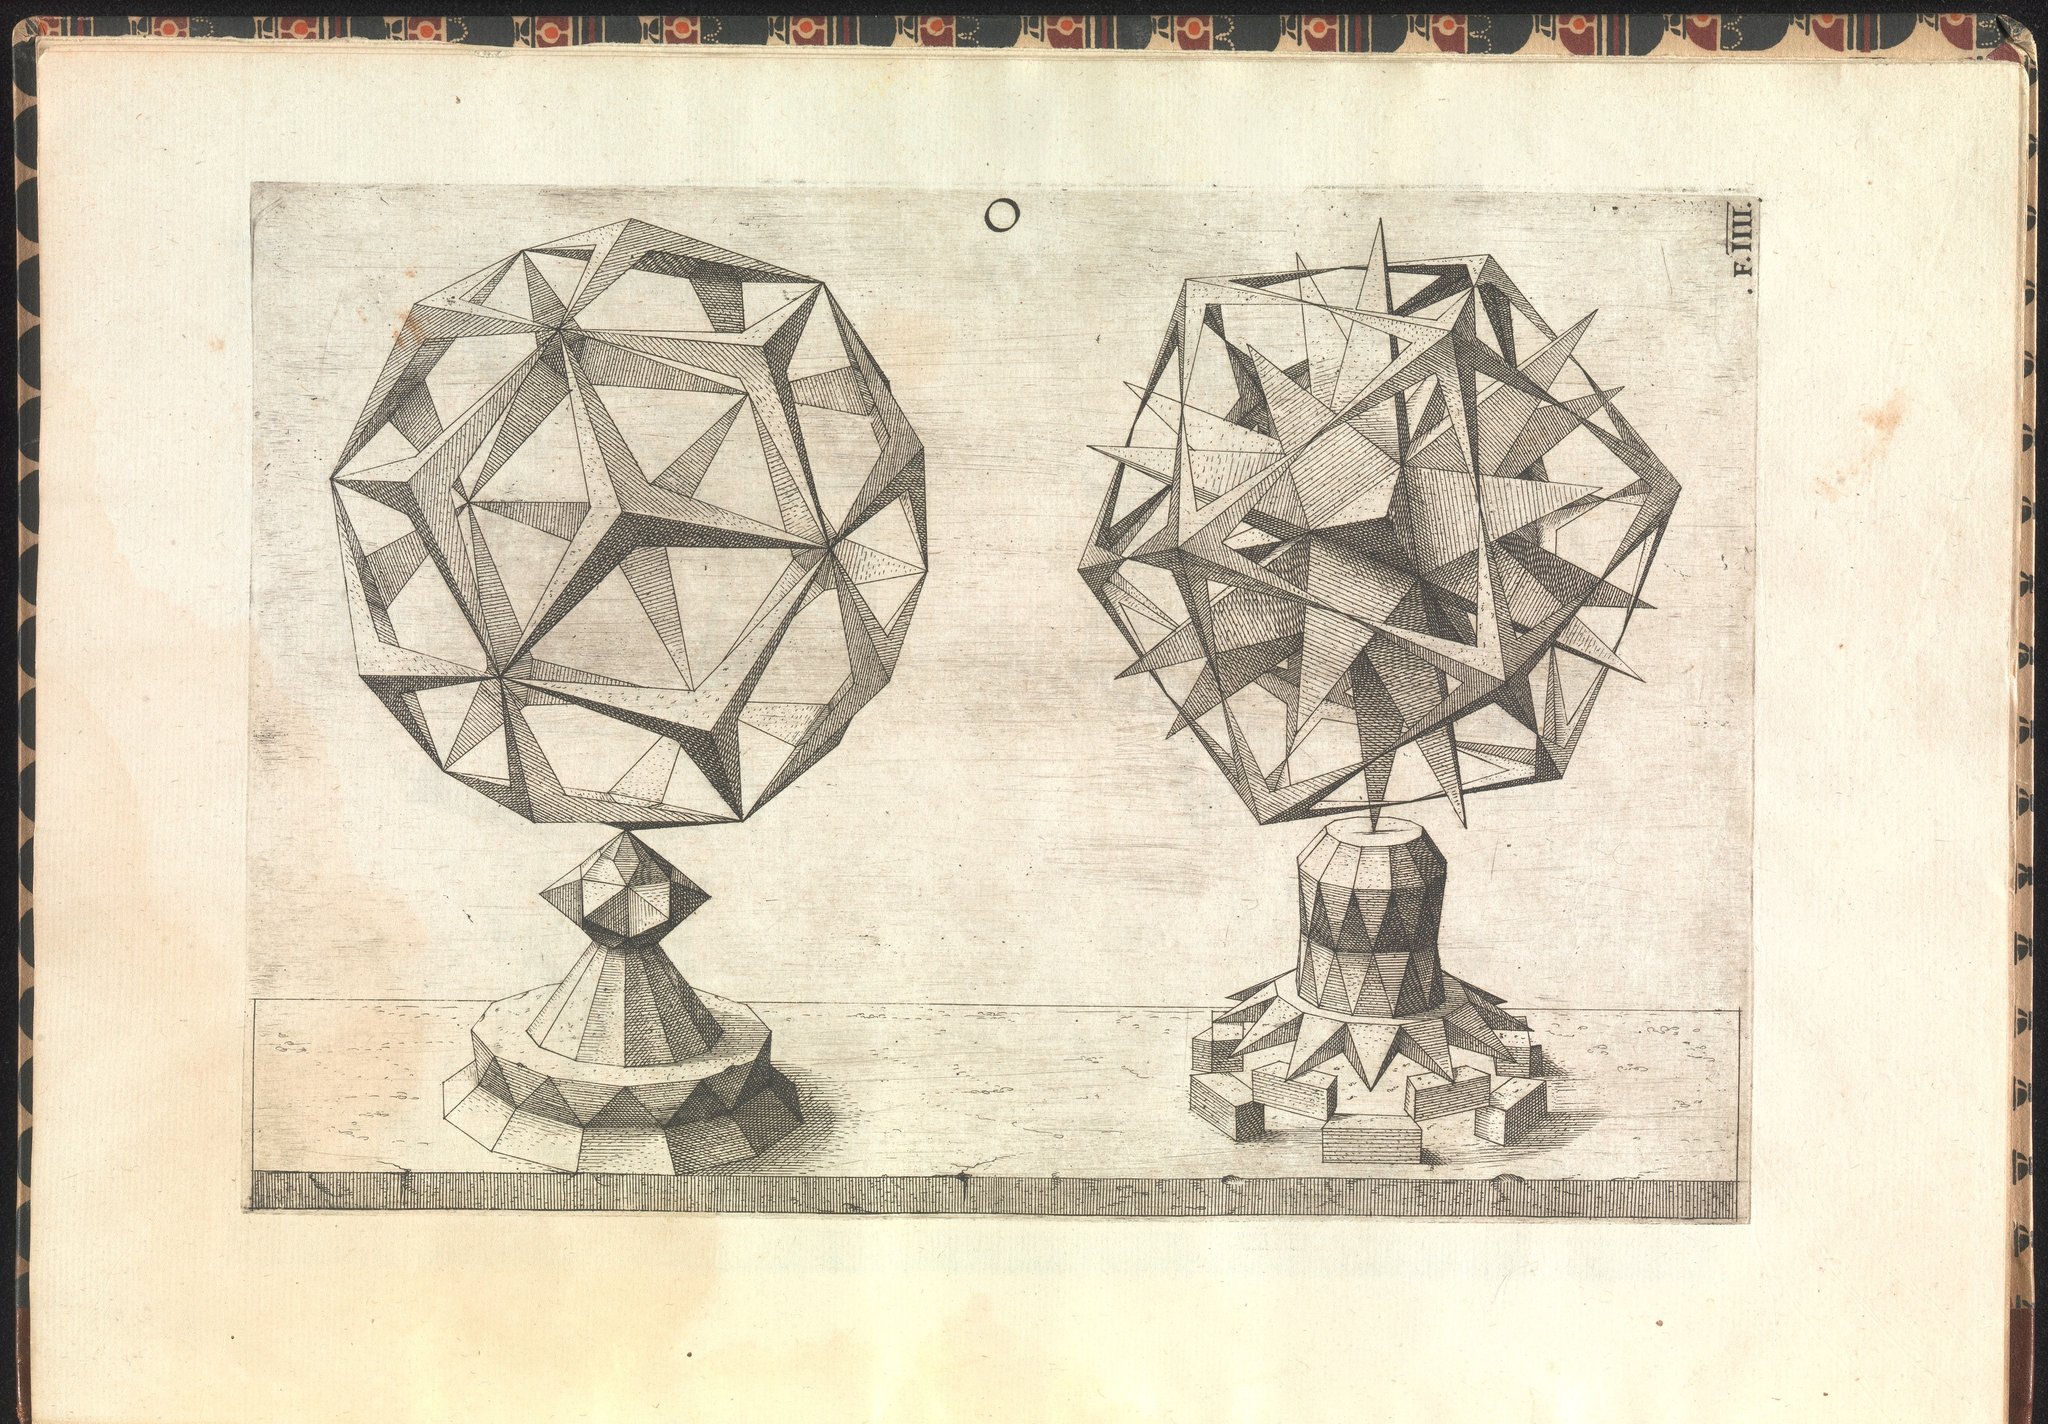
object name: book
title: Perspectiva Corporum Regularium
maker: jost amman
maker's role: engraver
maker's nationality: swiss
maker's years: 1539-1591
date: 1568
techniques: etching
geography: germany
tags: geometry